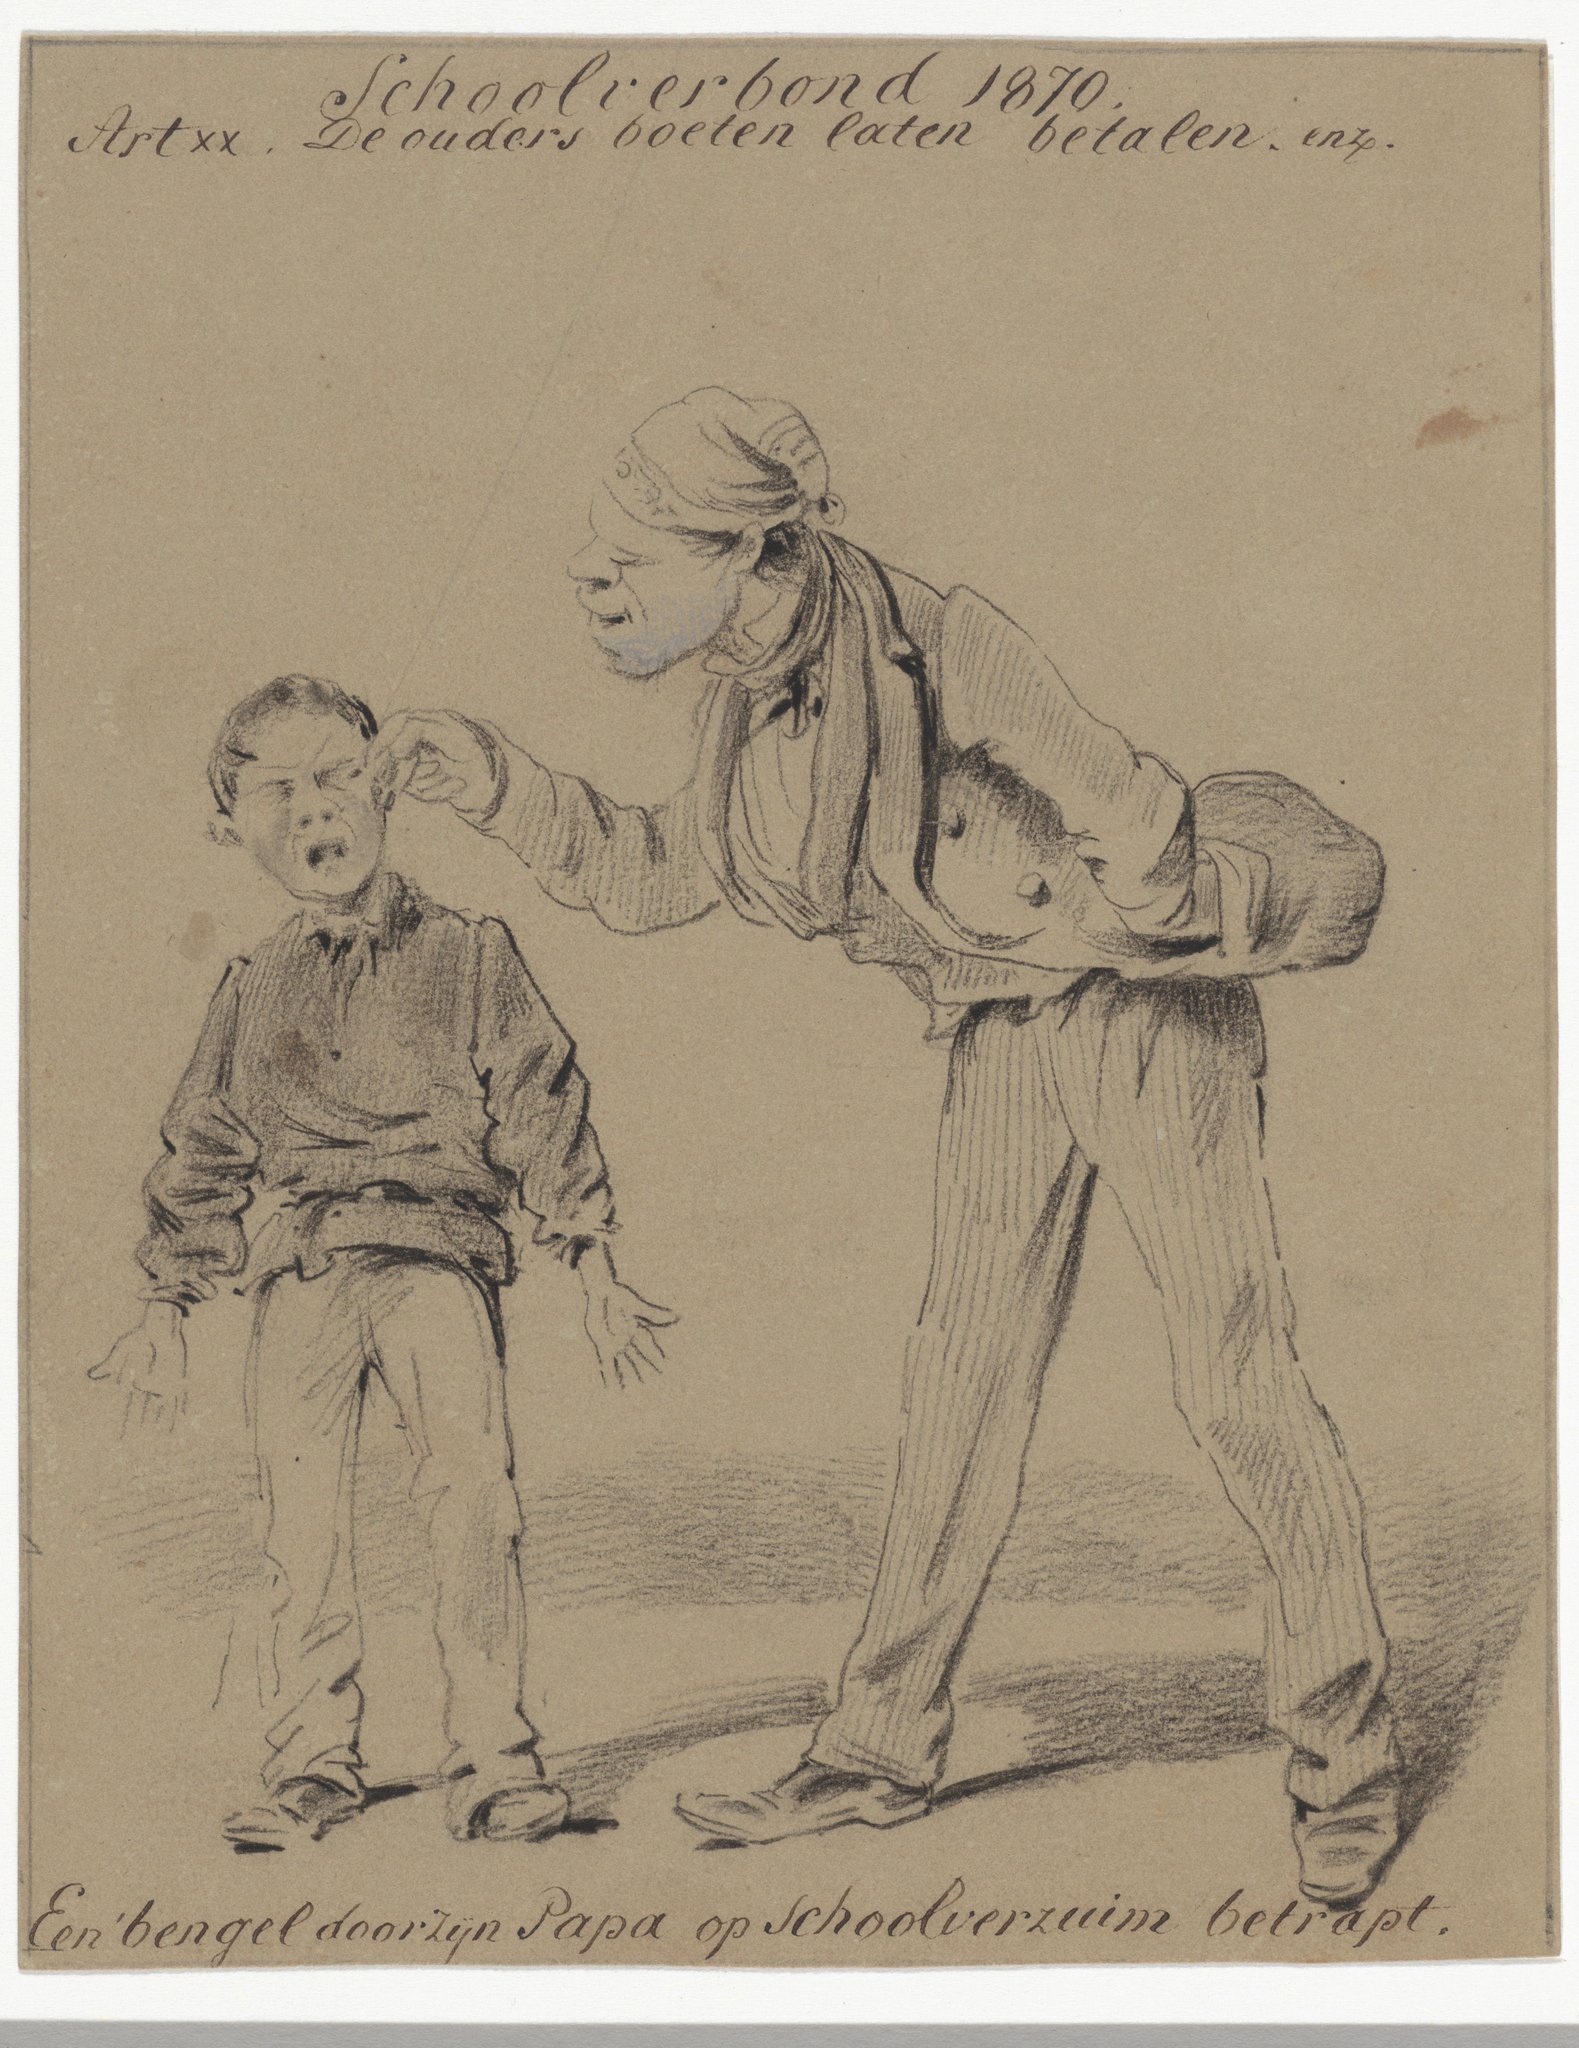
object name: drawing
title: Een bengel door zijn Papa op schoolverzuim betrapt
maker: pieter van loon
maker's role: draughtsman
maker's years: 1801-1873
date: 1870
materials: chalk, paper